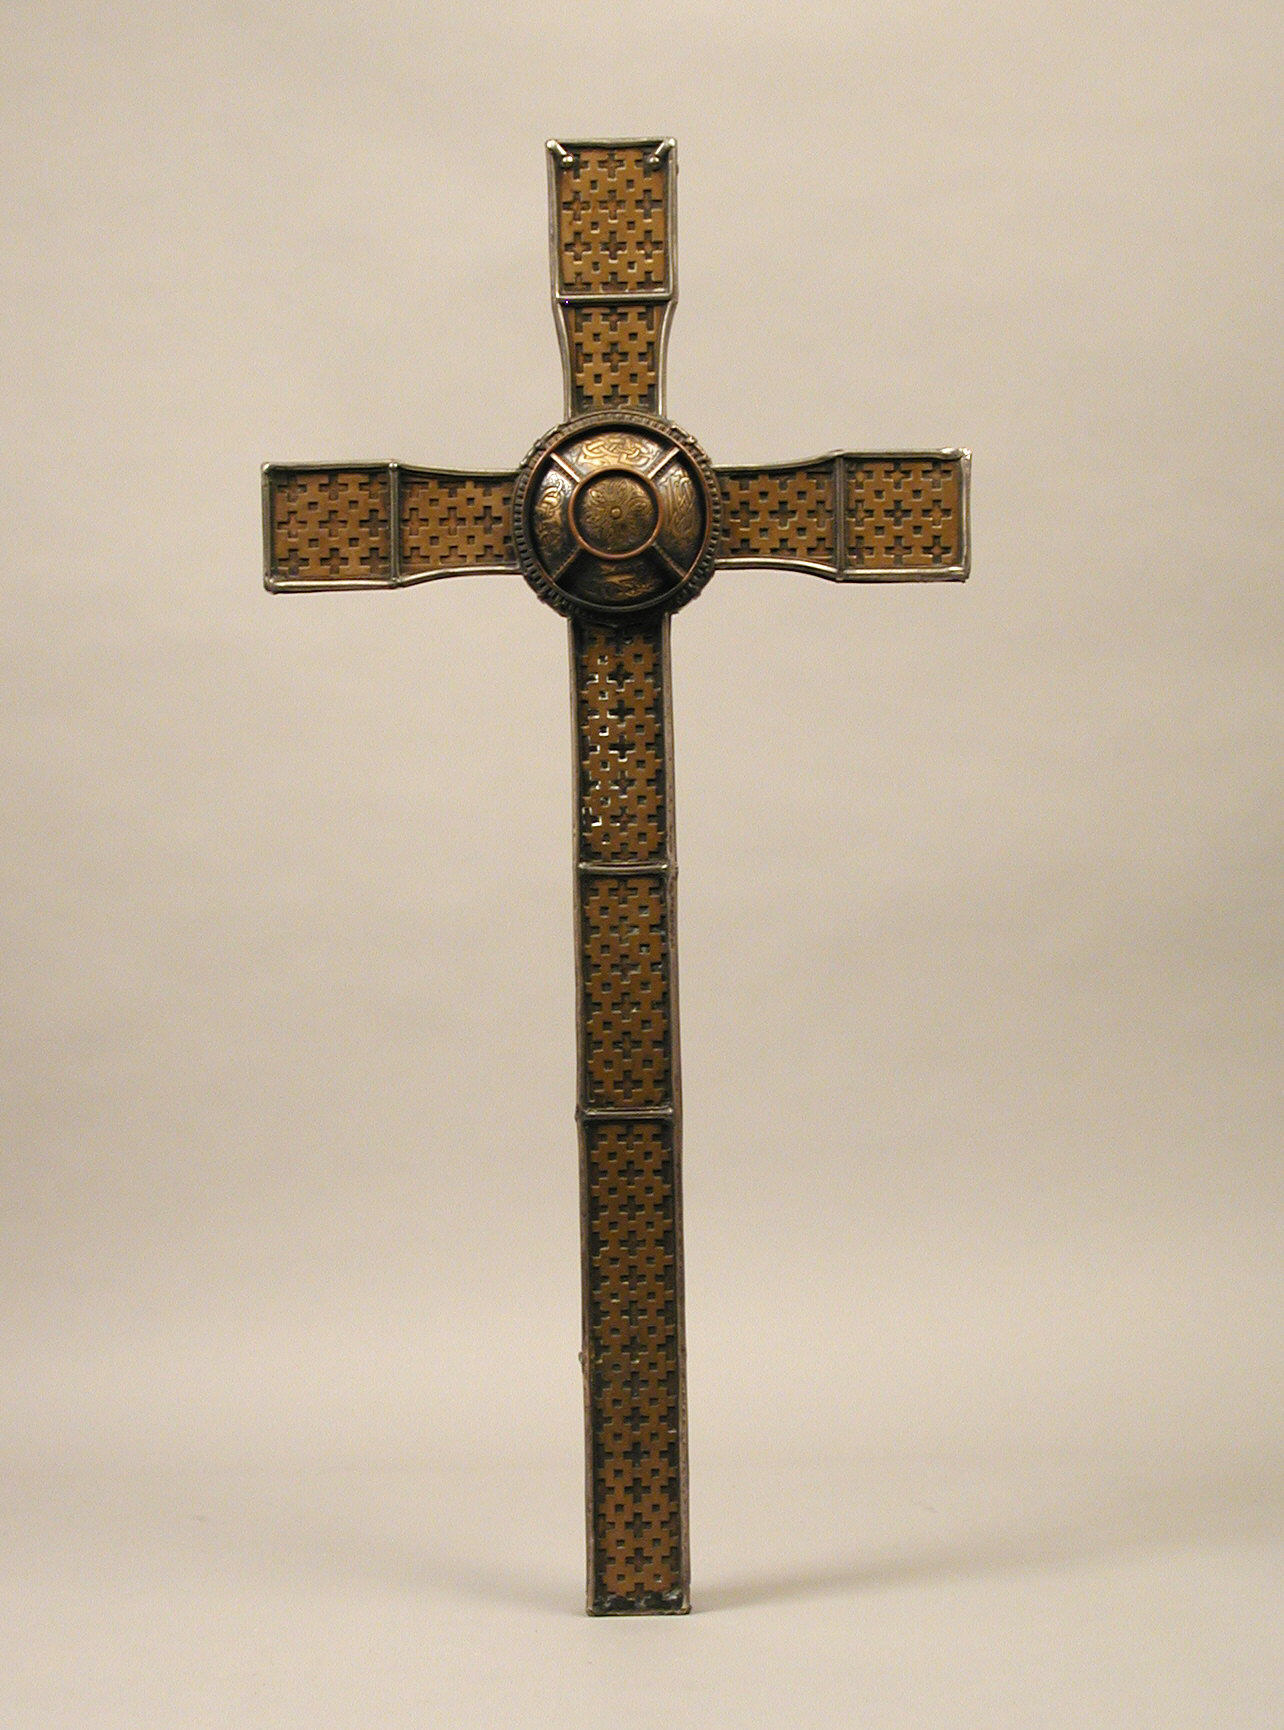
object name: cross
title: Cross of Clogher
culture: irish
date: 1901-1933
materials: bronze, wood, silver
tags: human figures